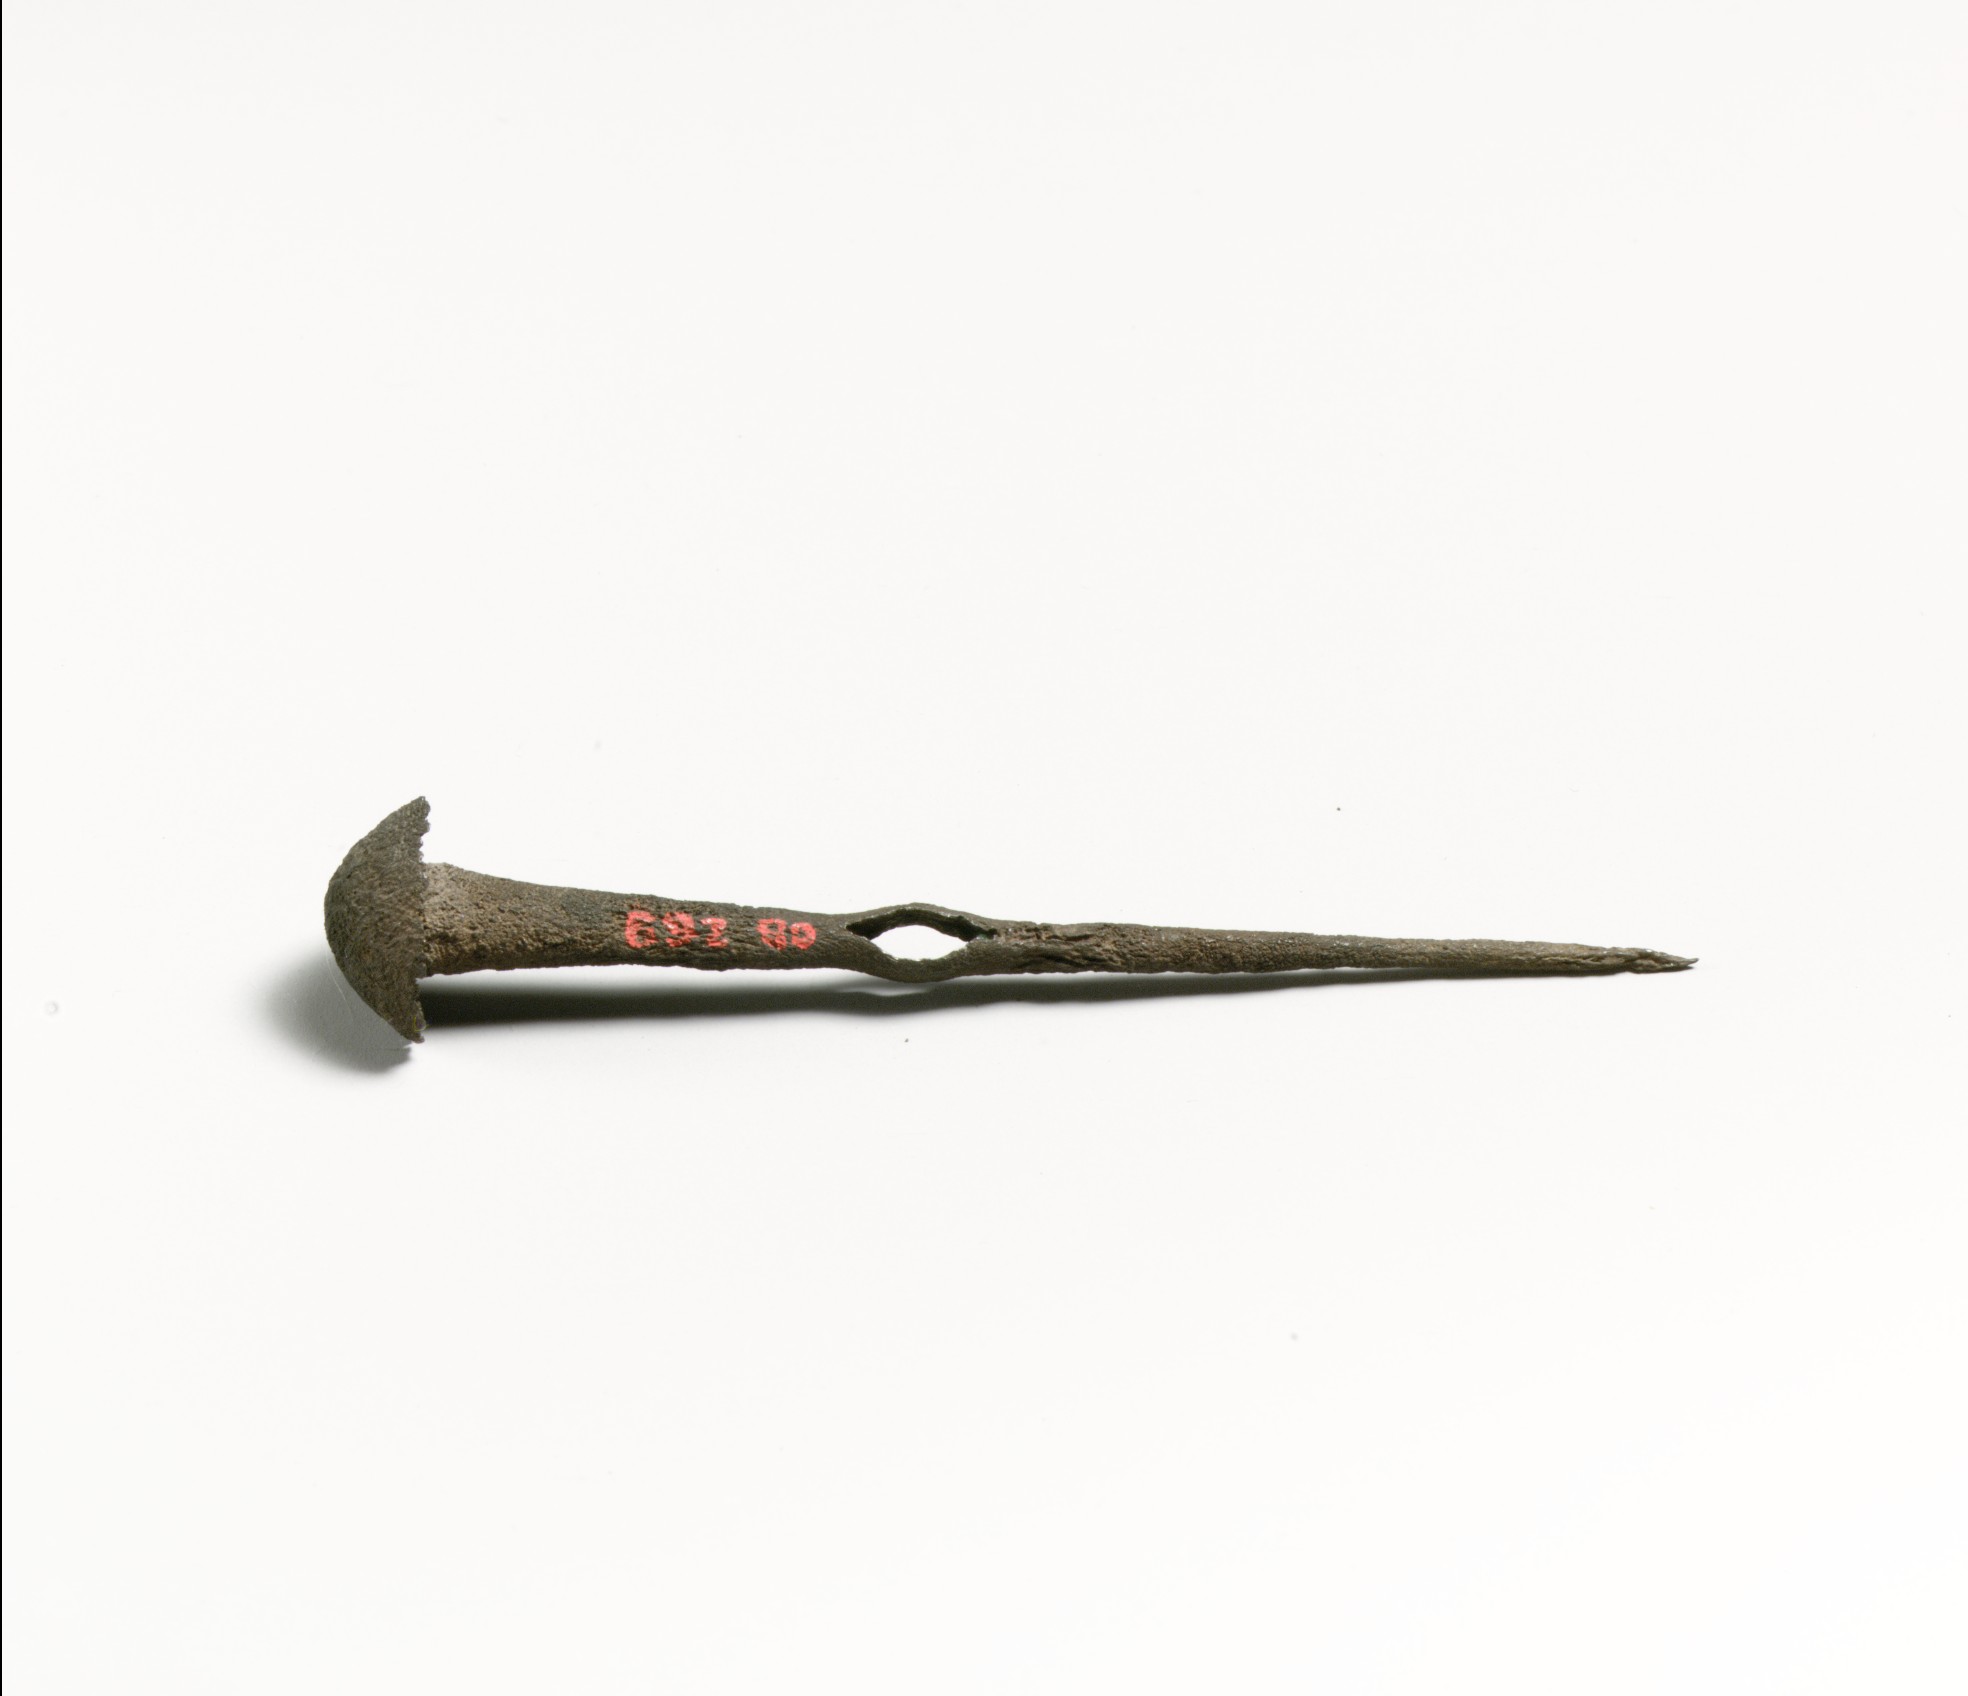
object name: pin, eyelet type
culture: cypriot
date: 3900 BCE-100 CE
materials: bronze